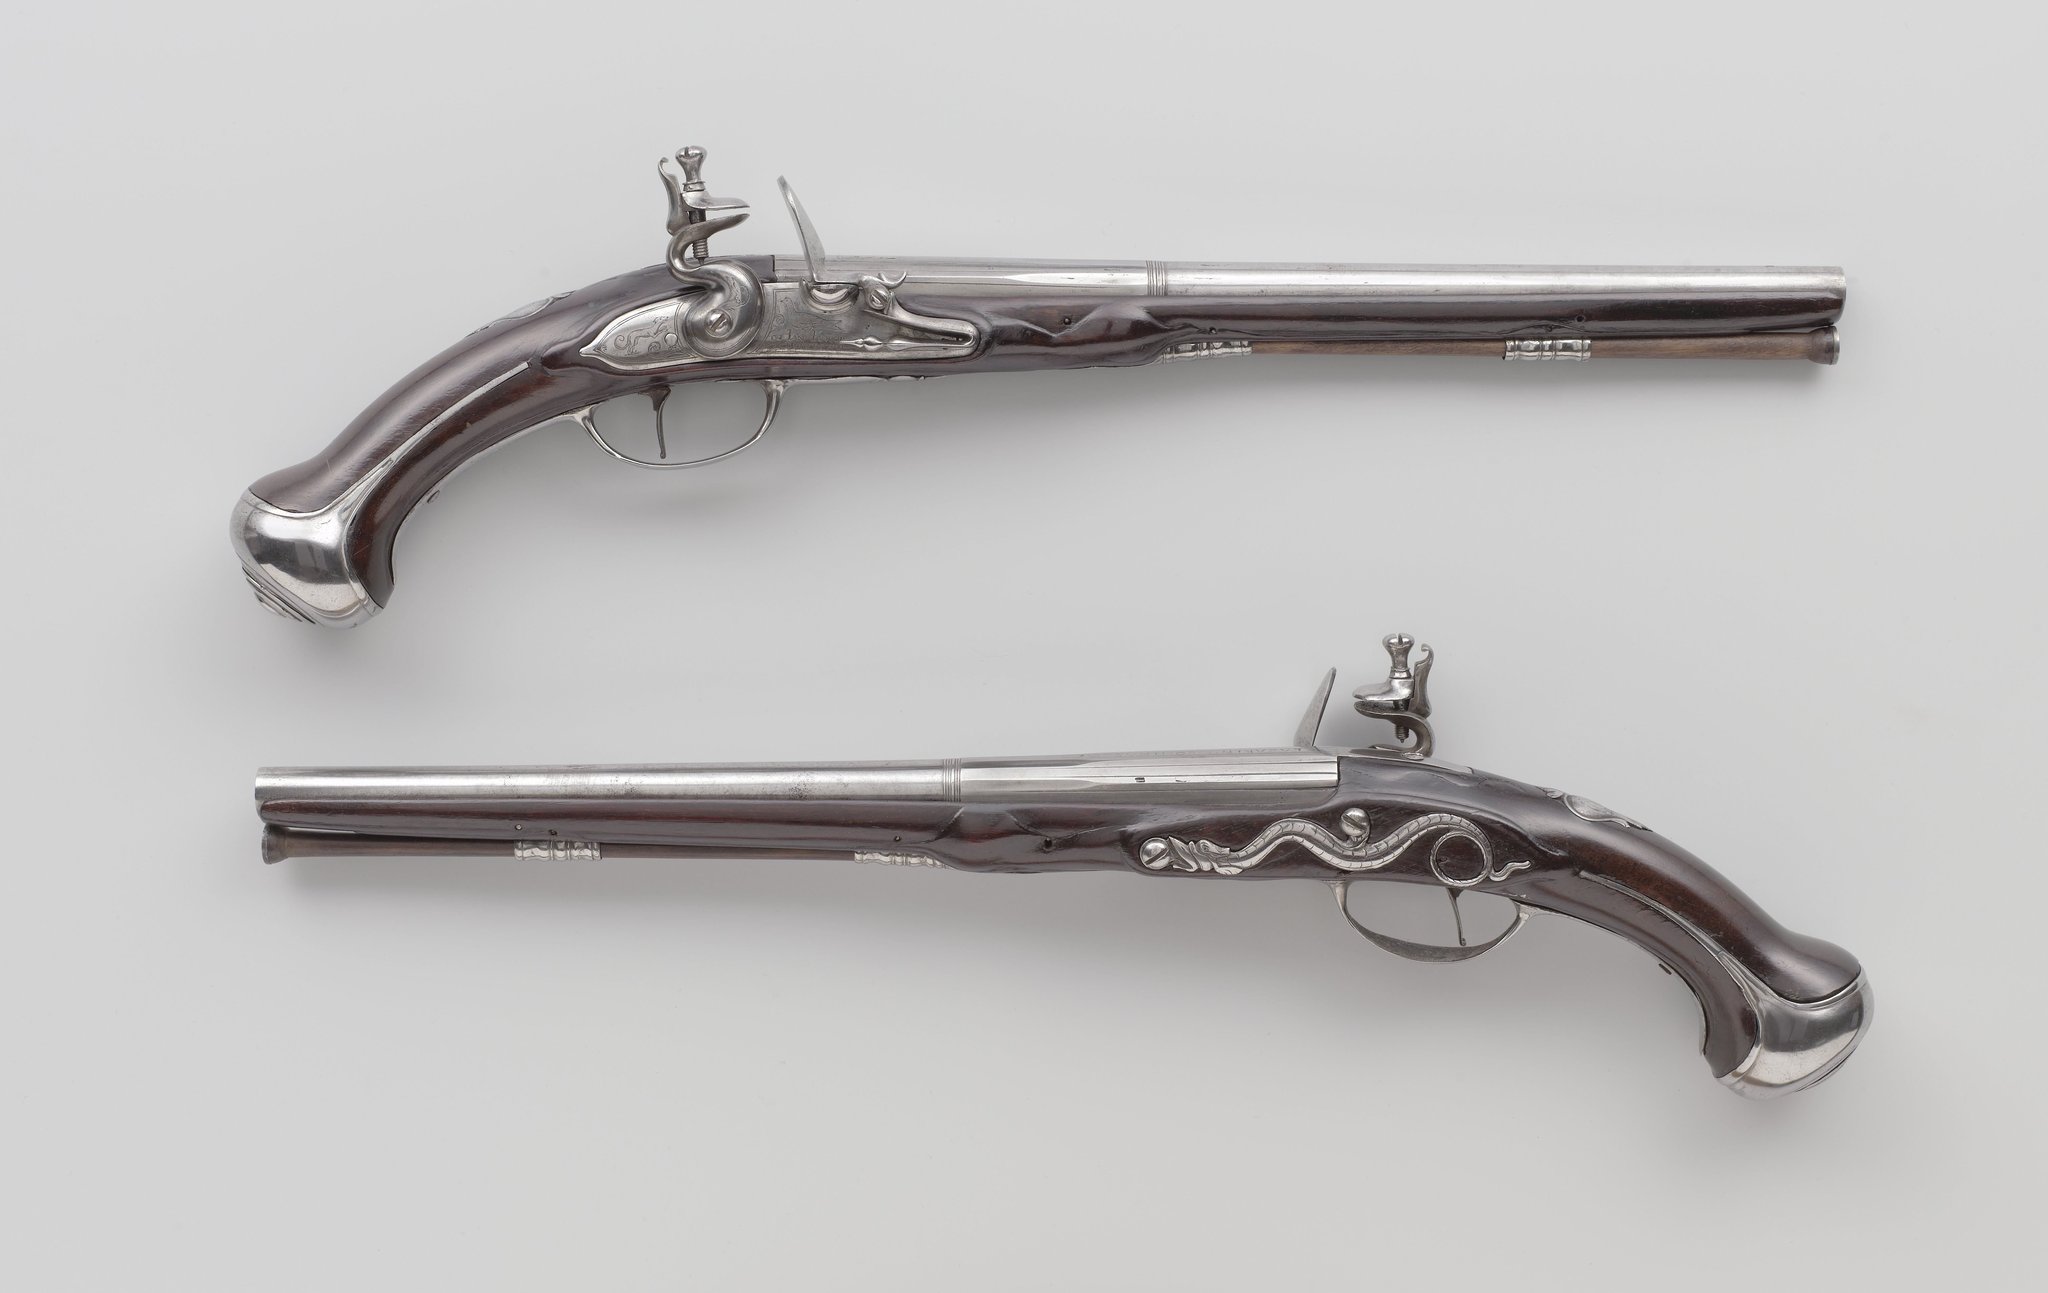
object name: flintlock pistol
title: Vuursteenpistool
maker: jan knoop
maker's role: geweermaker, lademaker, pistoolmaker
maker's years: 1610-1688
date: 1689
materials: iron, wood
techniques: printing, cutting, engraving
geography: utrecht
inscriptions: inscription: ‘* LAZARINO * COMINAZZO *; ZC’, inscription: ‘ov Ian Knoop // UTRECHT’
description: Deel van een koppel. De haan van het slot is gegraveerd met een slangenkop, de slotplaat met een hond en een jachtvogel, met daaronder de signatuur vergezeld van een embleem met een springend hert. De loop is bovenop gestempeld met * LAZARINO * COMINAZZO * en onderop met ZC onder een ster. De kolf van gezwart notenhout is eenvoudig gesneden. Het ijzeren beslag bestaat onder andere uit een schroefplaat in de vorm van een zeeslang met een gekrulde staart, een gekroonde, hartvormige duimplaat met een ongeïdentificeerd heraldisch wapen en een onversierde kolfkap met lange kolfkapsporen en een concentrisch getrapte kolfdekplaat; de laadstok is voorzien van een ijzeren kap.